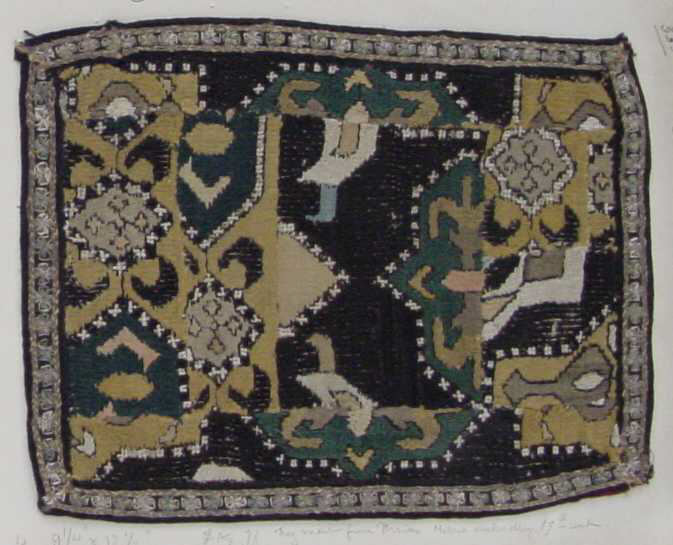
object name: textile fragment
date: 1601-1700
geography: iran